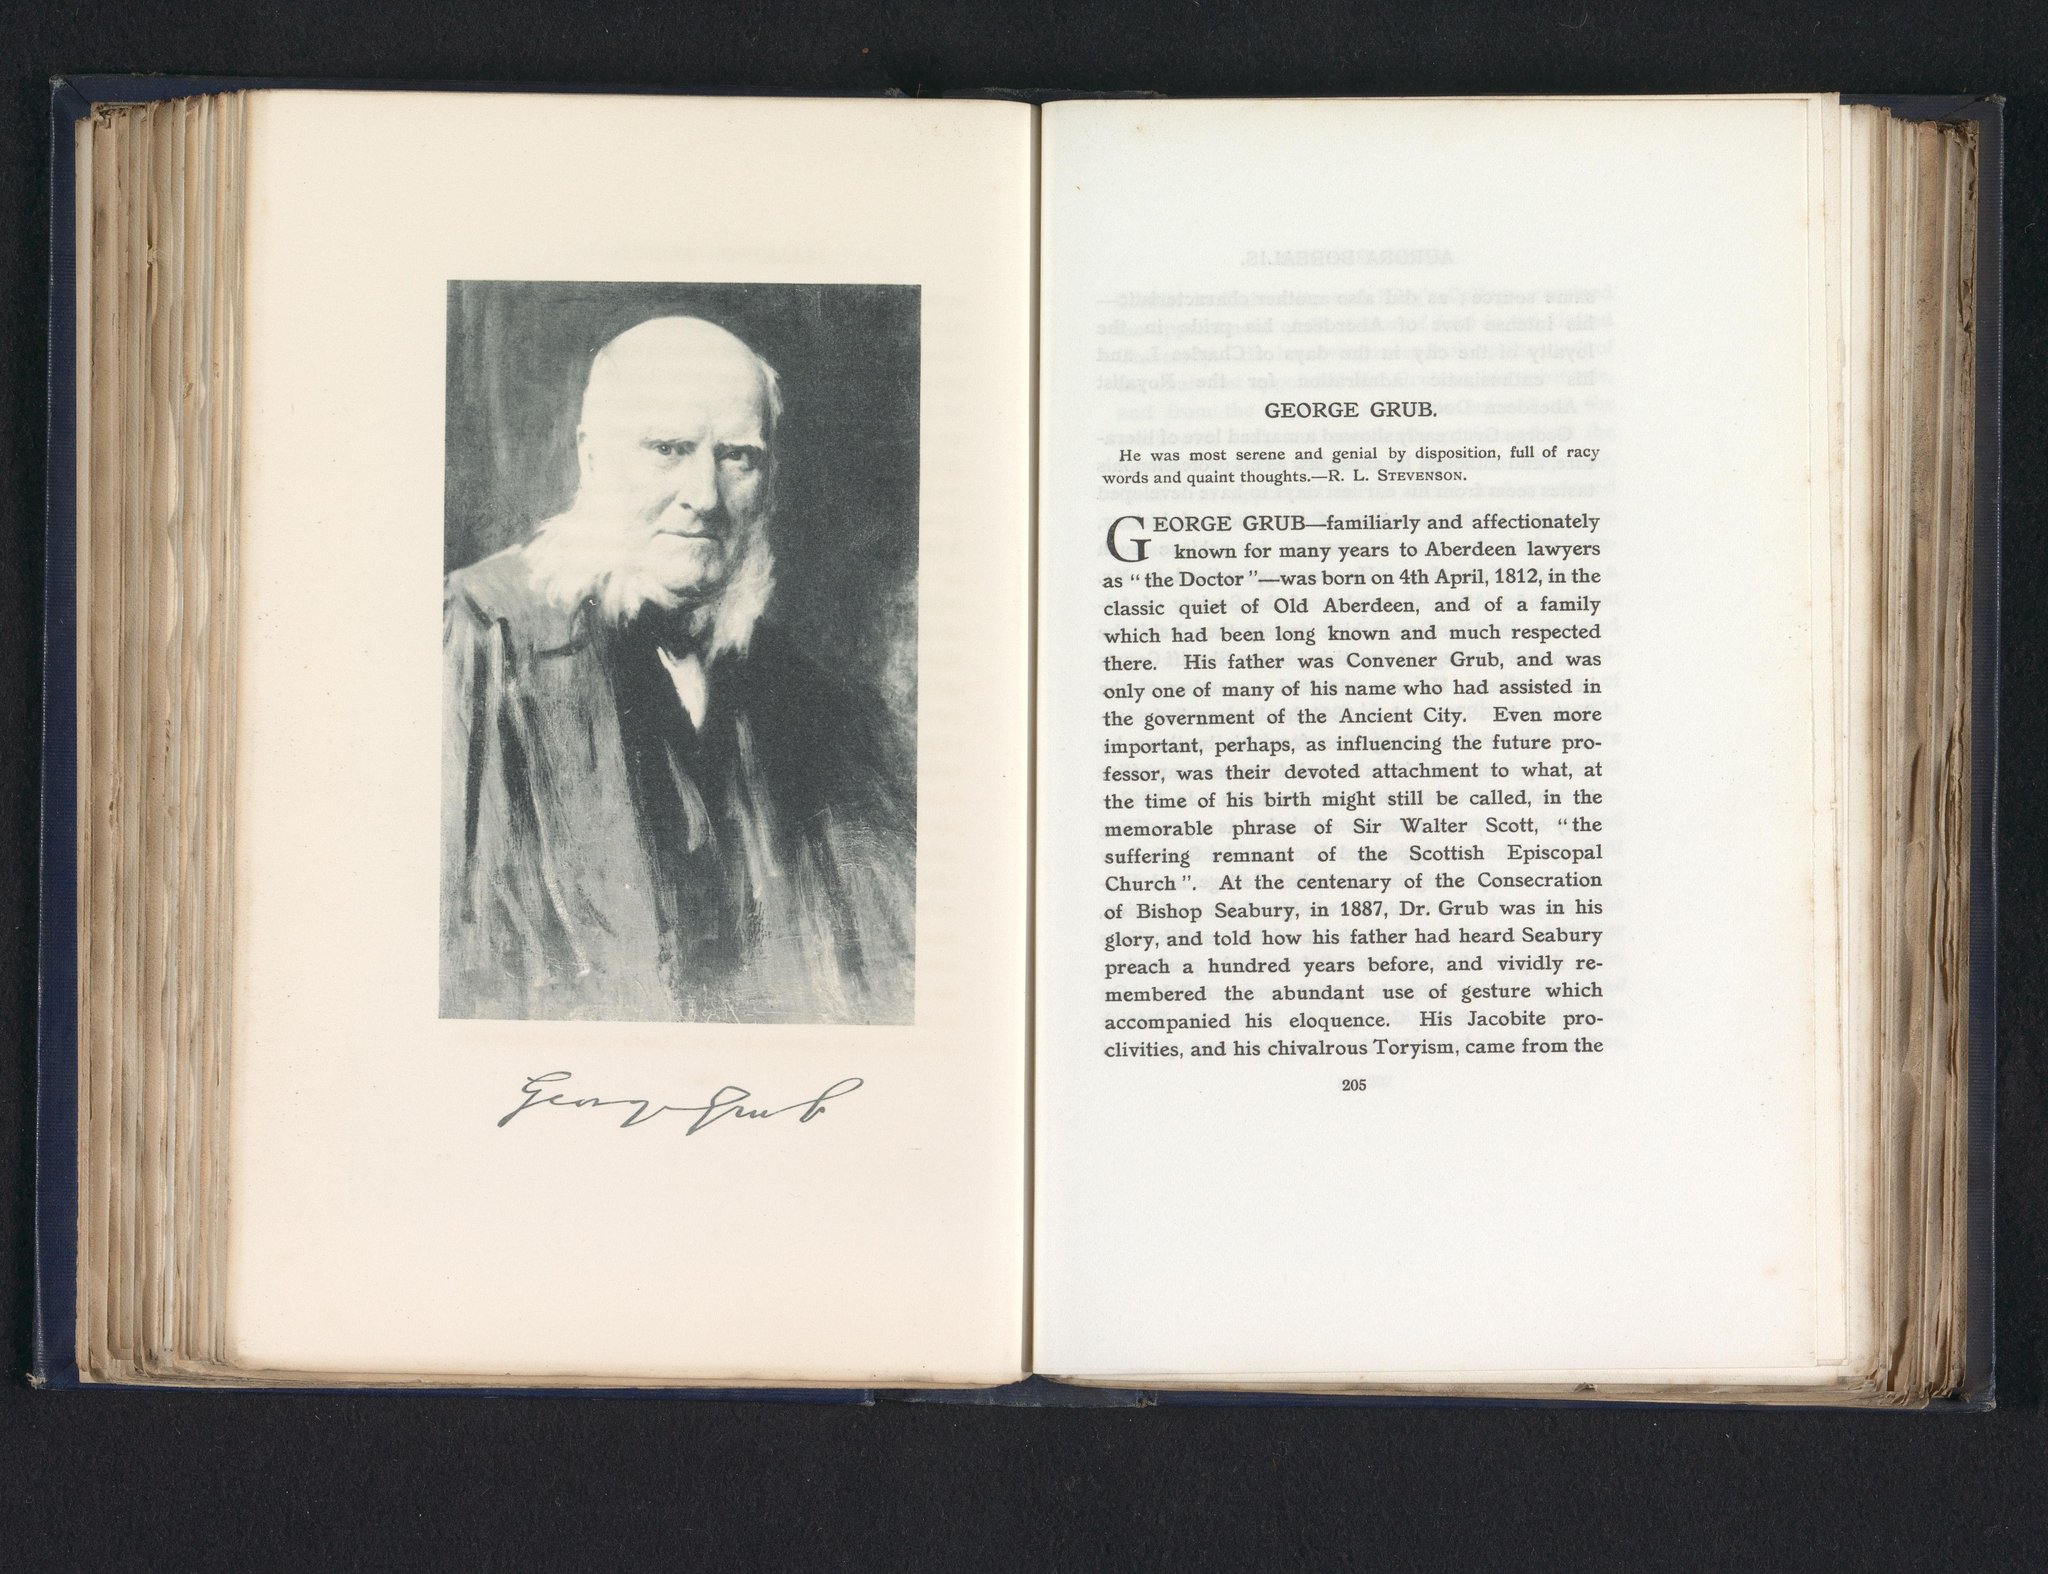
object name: page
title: George Grub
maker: Anonymous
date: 1882-1892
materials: paper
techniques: photograph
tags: scholar, philosopher